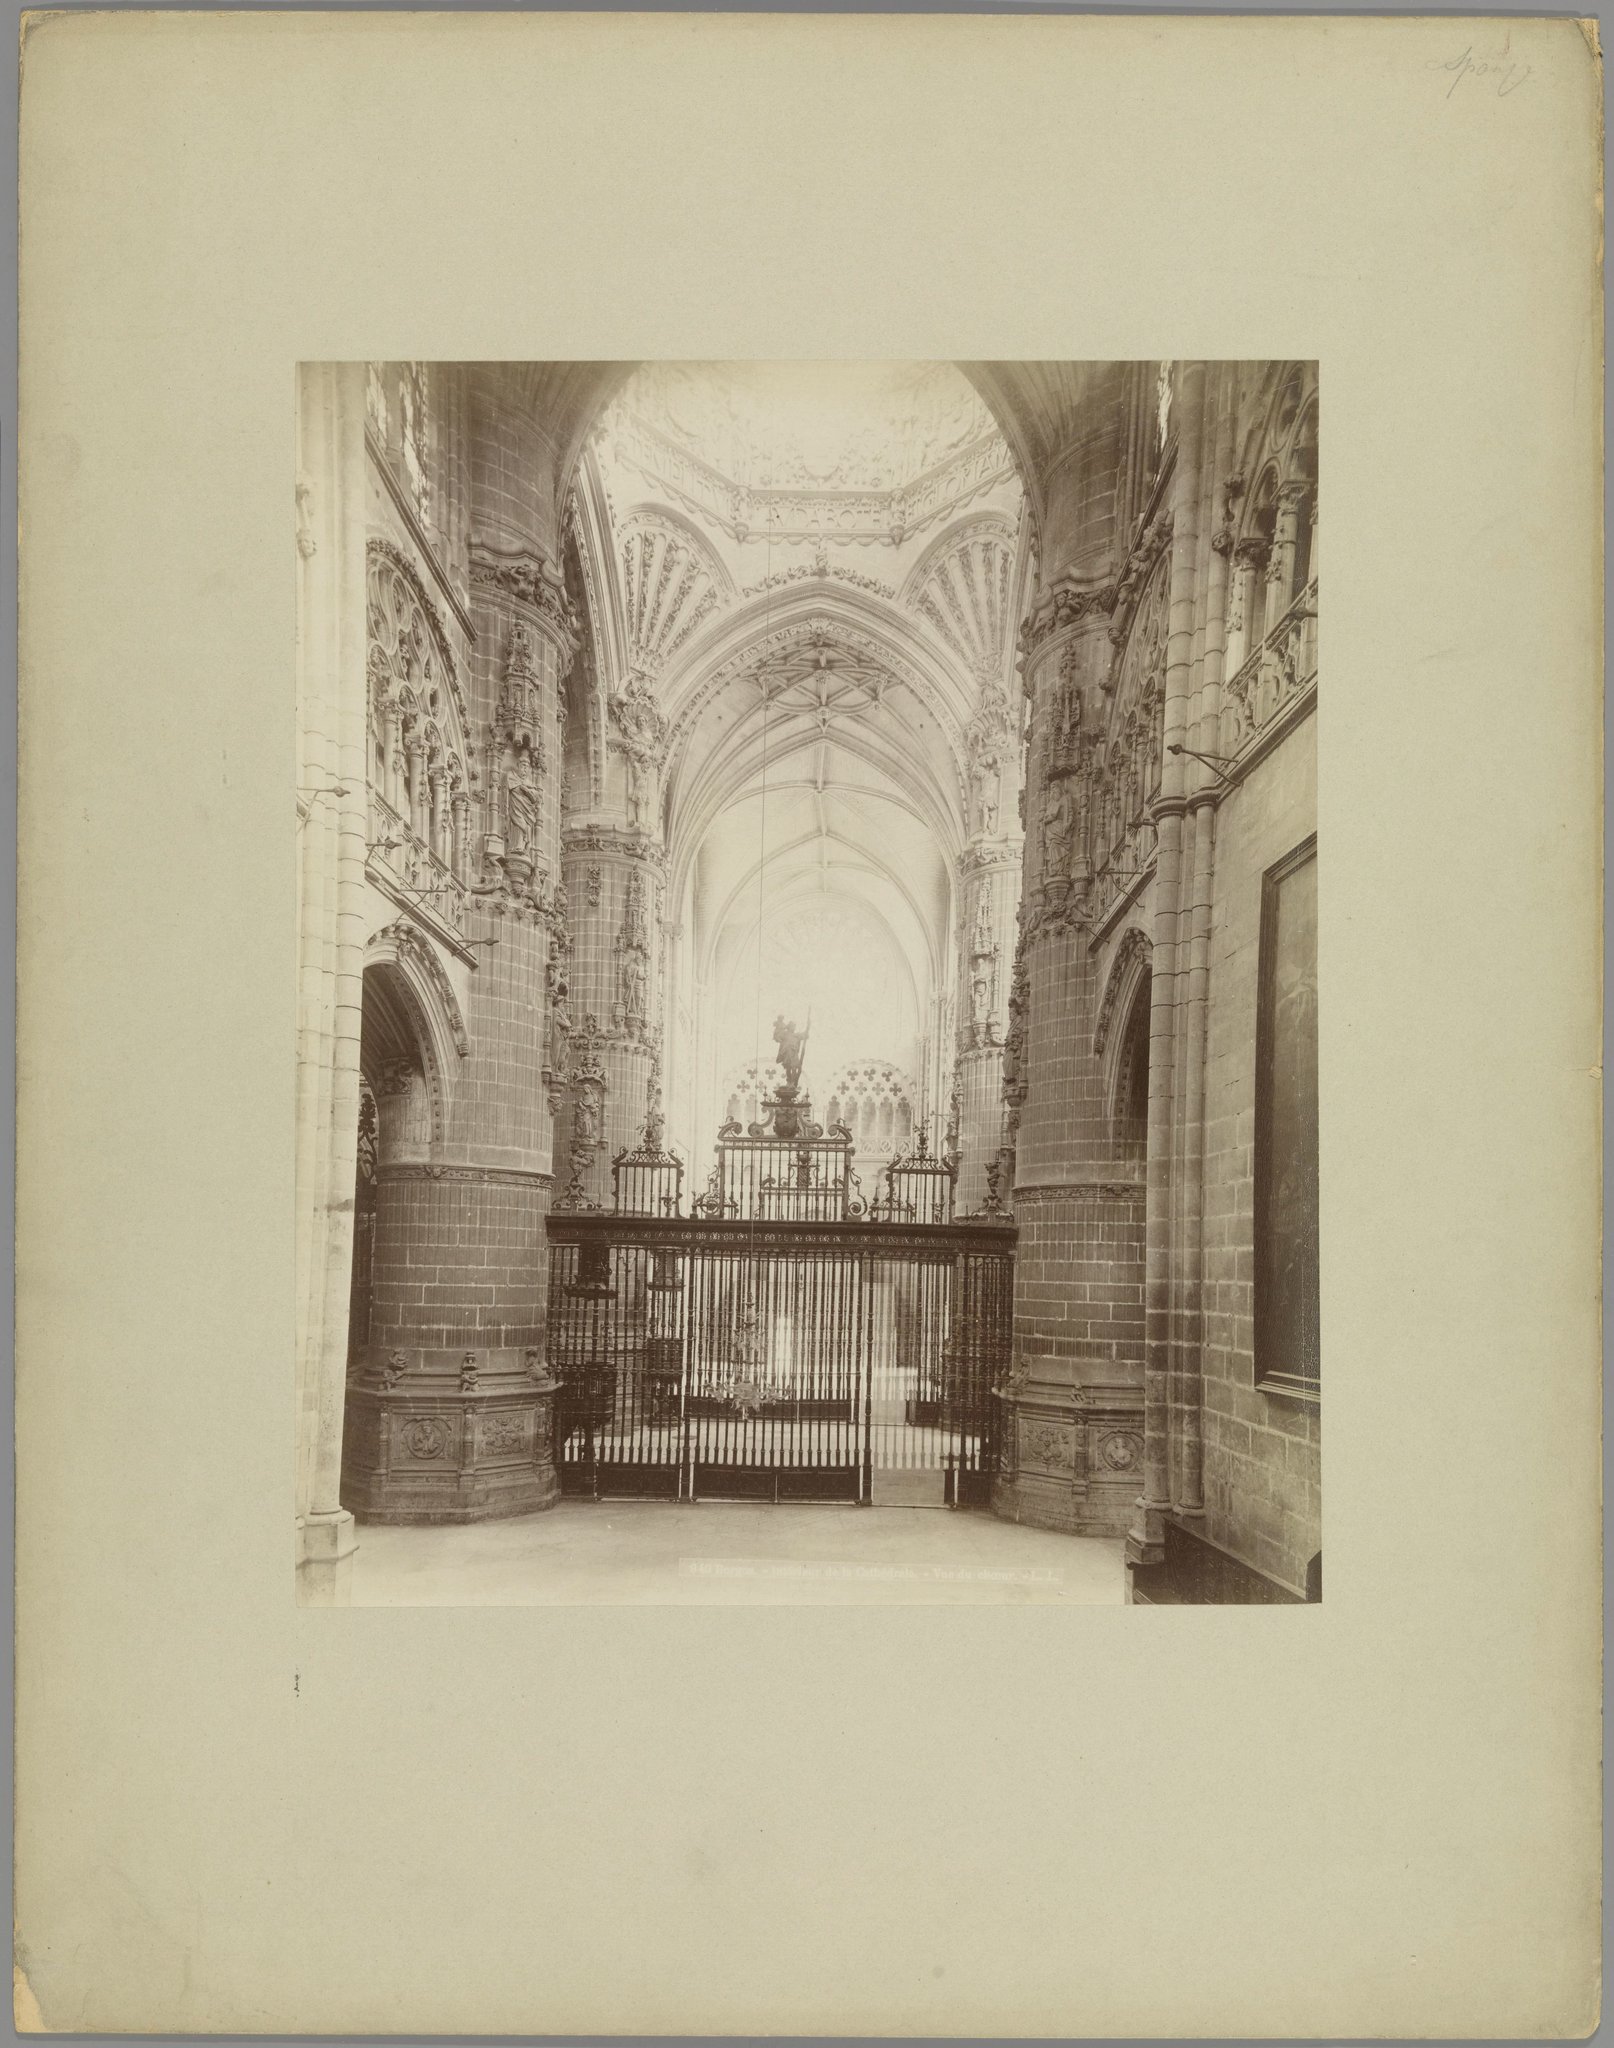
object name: photograph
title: Interieur van de Kathedraal te Burgos gezien naar het koor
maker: Anonymous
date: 1875-1900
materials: cardboard, photographic support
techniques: albumen print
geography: burgos cathedral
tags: parts of church interior: choir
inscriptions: number: ‘949’, inscription: ‘L. L.’, collector's mark: Lugt 3937